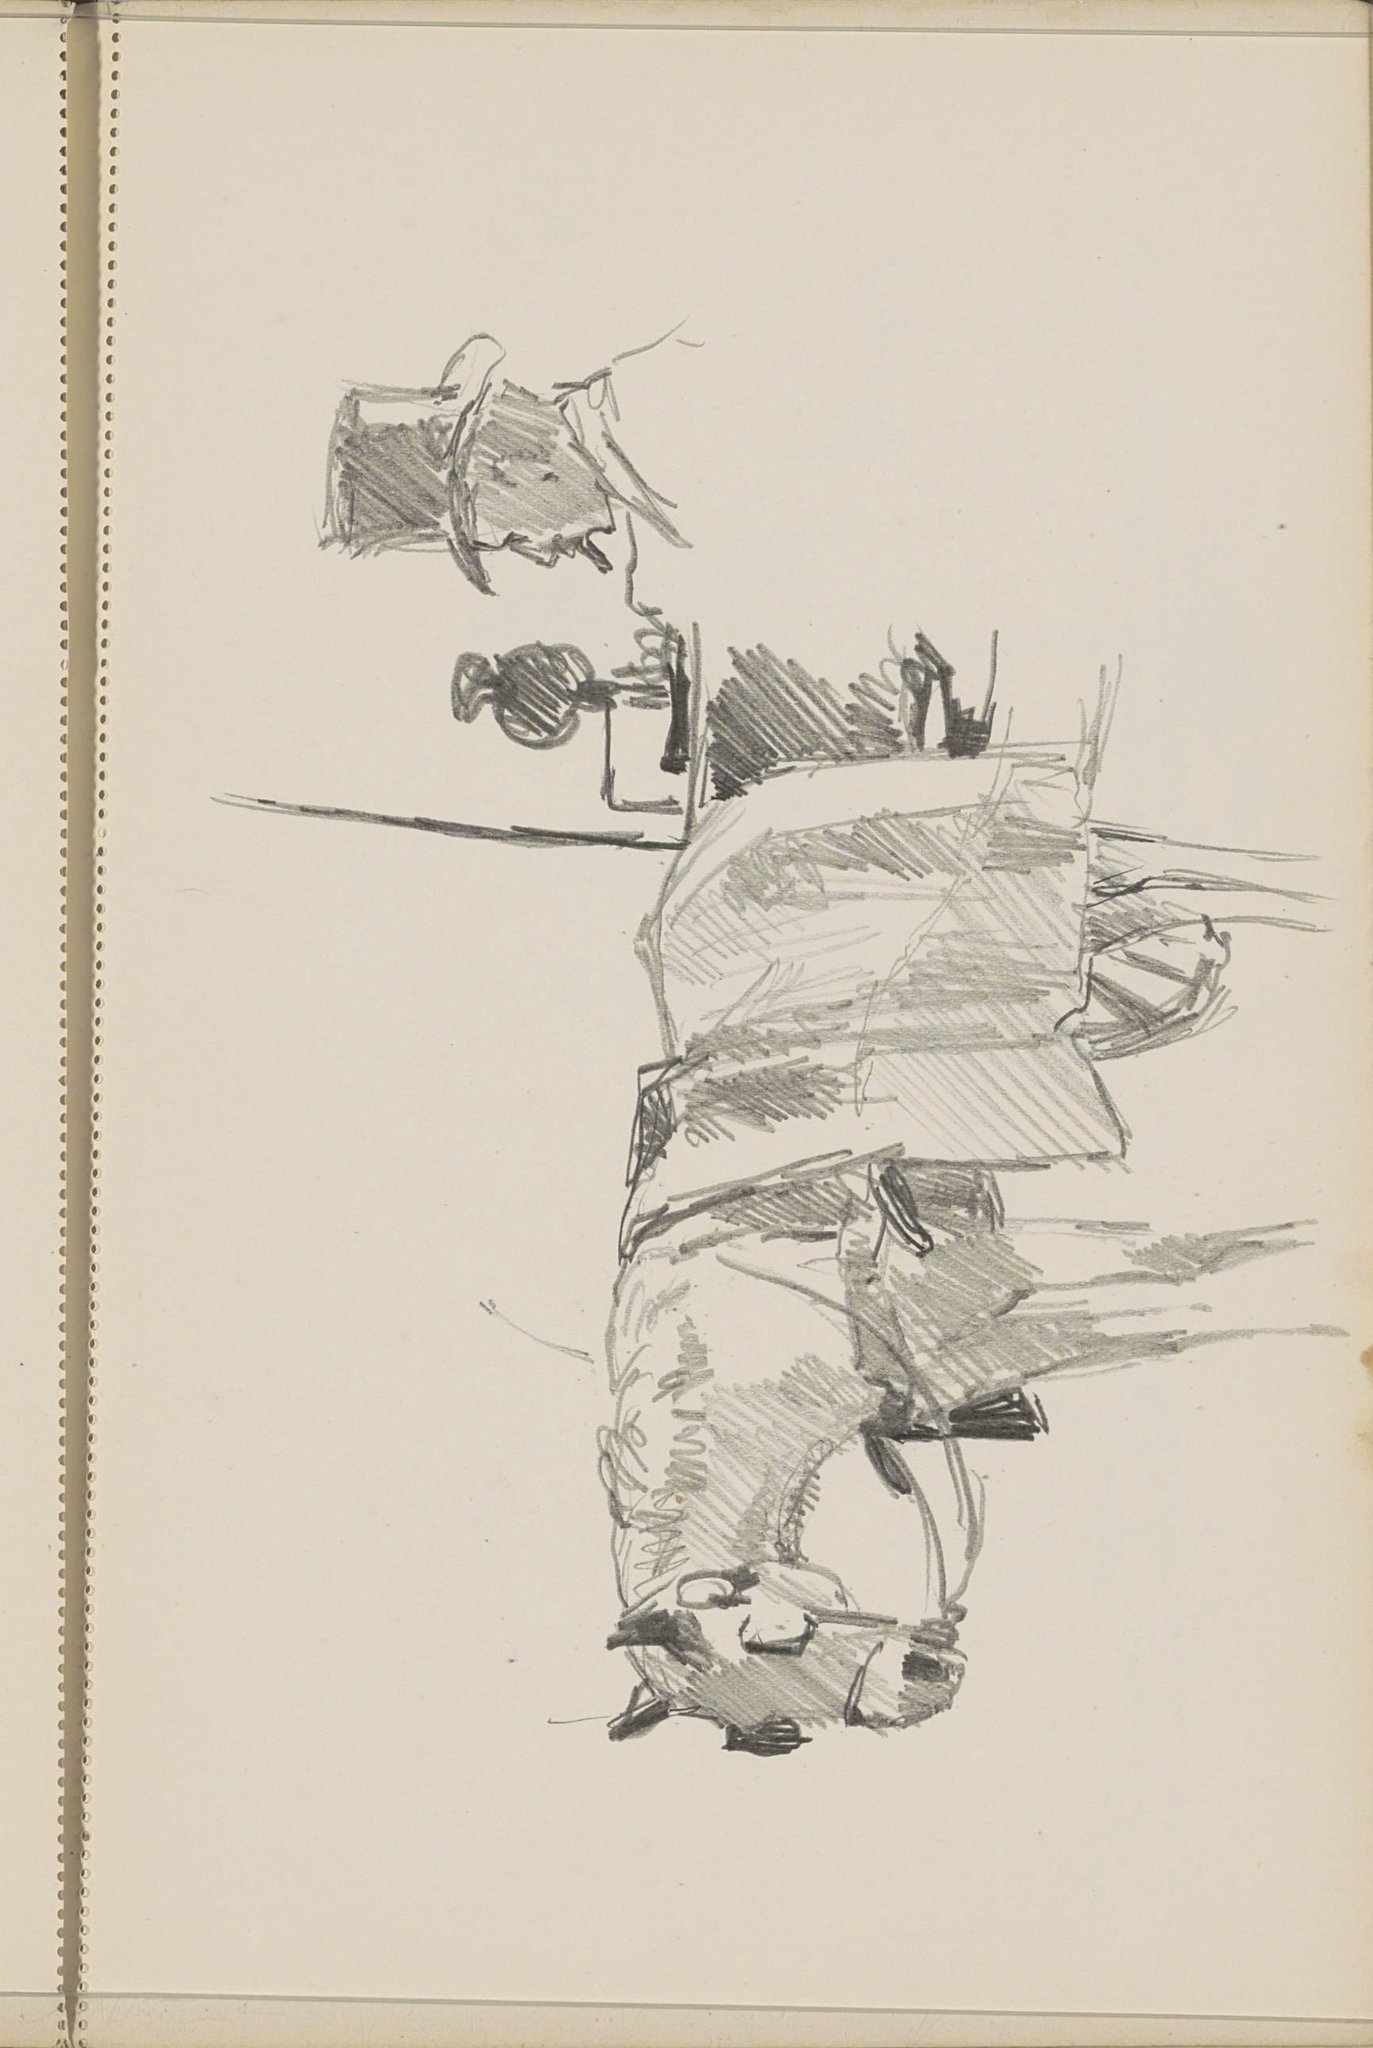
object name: sketchbook leaf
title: Paard en een man met een sigaar en hoge hoed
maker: cornelis vreedenburgh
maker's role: draughtsman, print maker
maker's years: 1880-1946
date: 1890-1946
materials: paper, pencil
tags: horse, head-gear: top hat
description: Mogelijk een koetsier en een paard dat het rijtuig trekt. Blad 50 recto uit een schetsboek met 59 bladen.